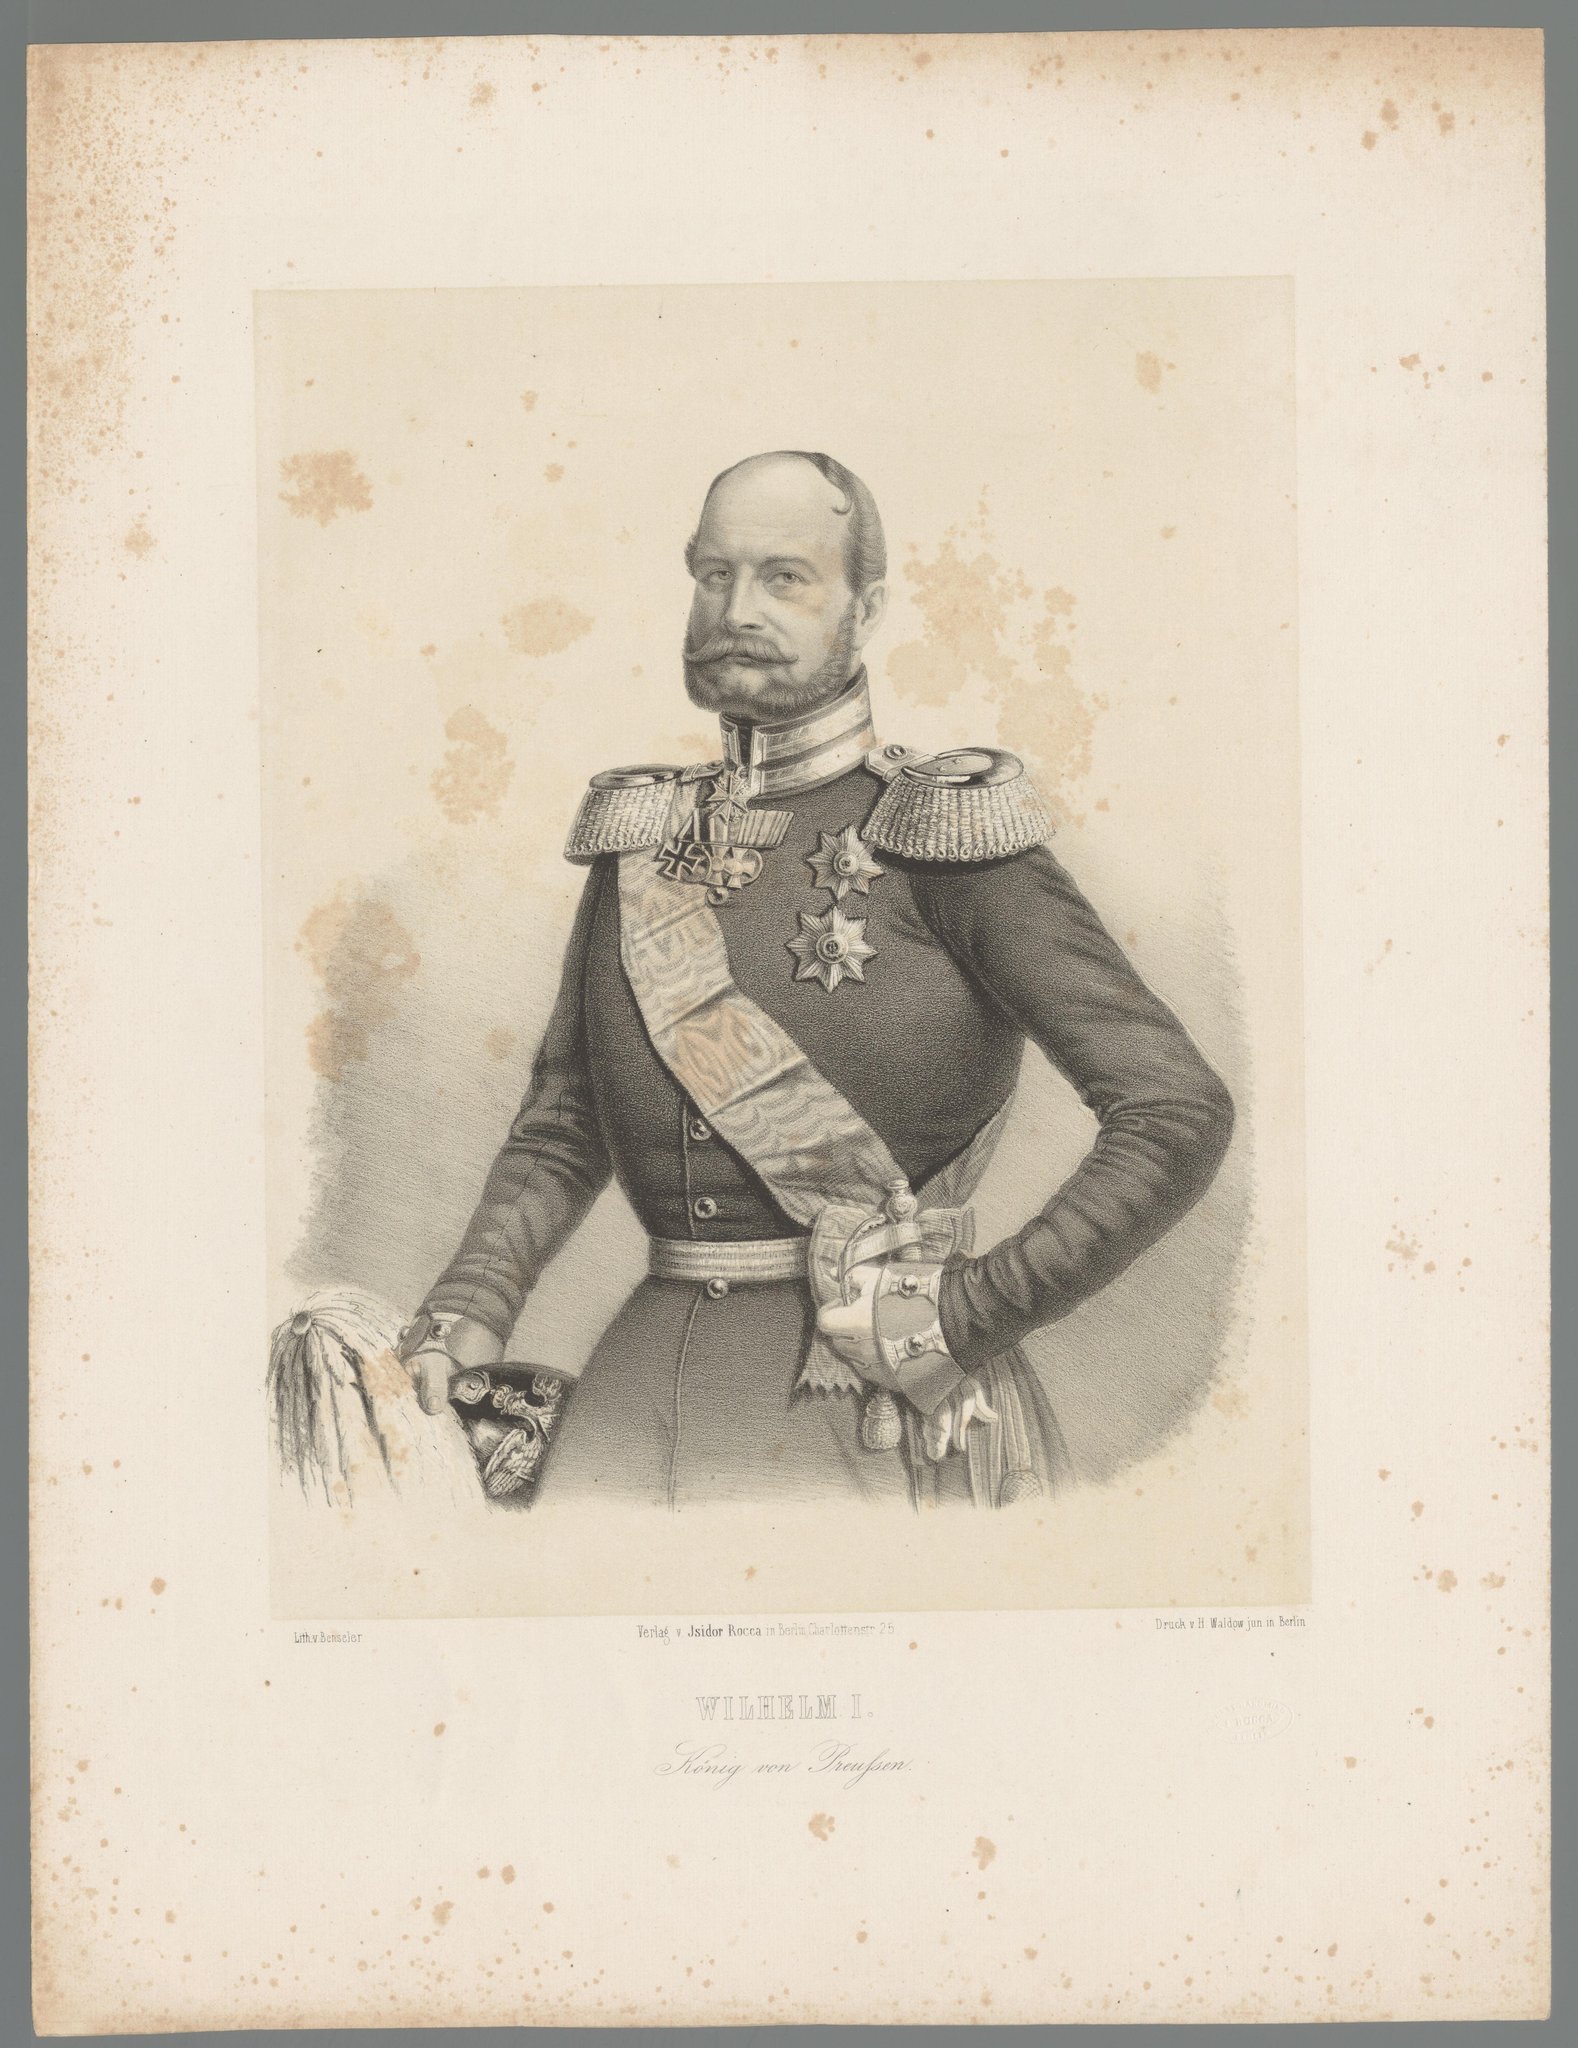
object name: print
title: Portret van Wilhelm I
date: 1850-1899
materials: paper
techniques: tone lithography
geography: berlin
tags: wilhelm i (keizer van duitsland), adult man, historical persons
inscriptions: check stamp: ‘Kunsthandlung I. Rocca Berlin’, collector's mark: Lugt 2228